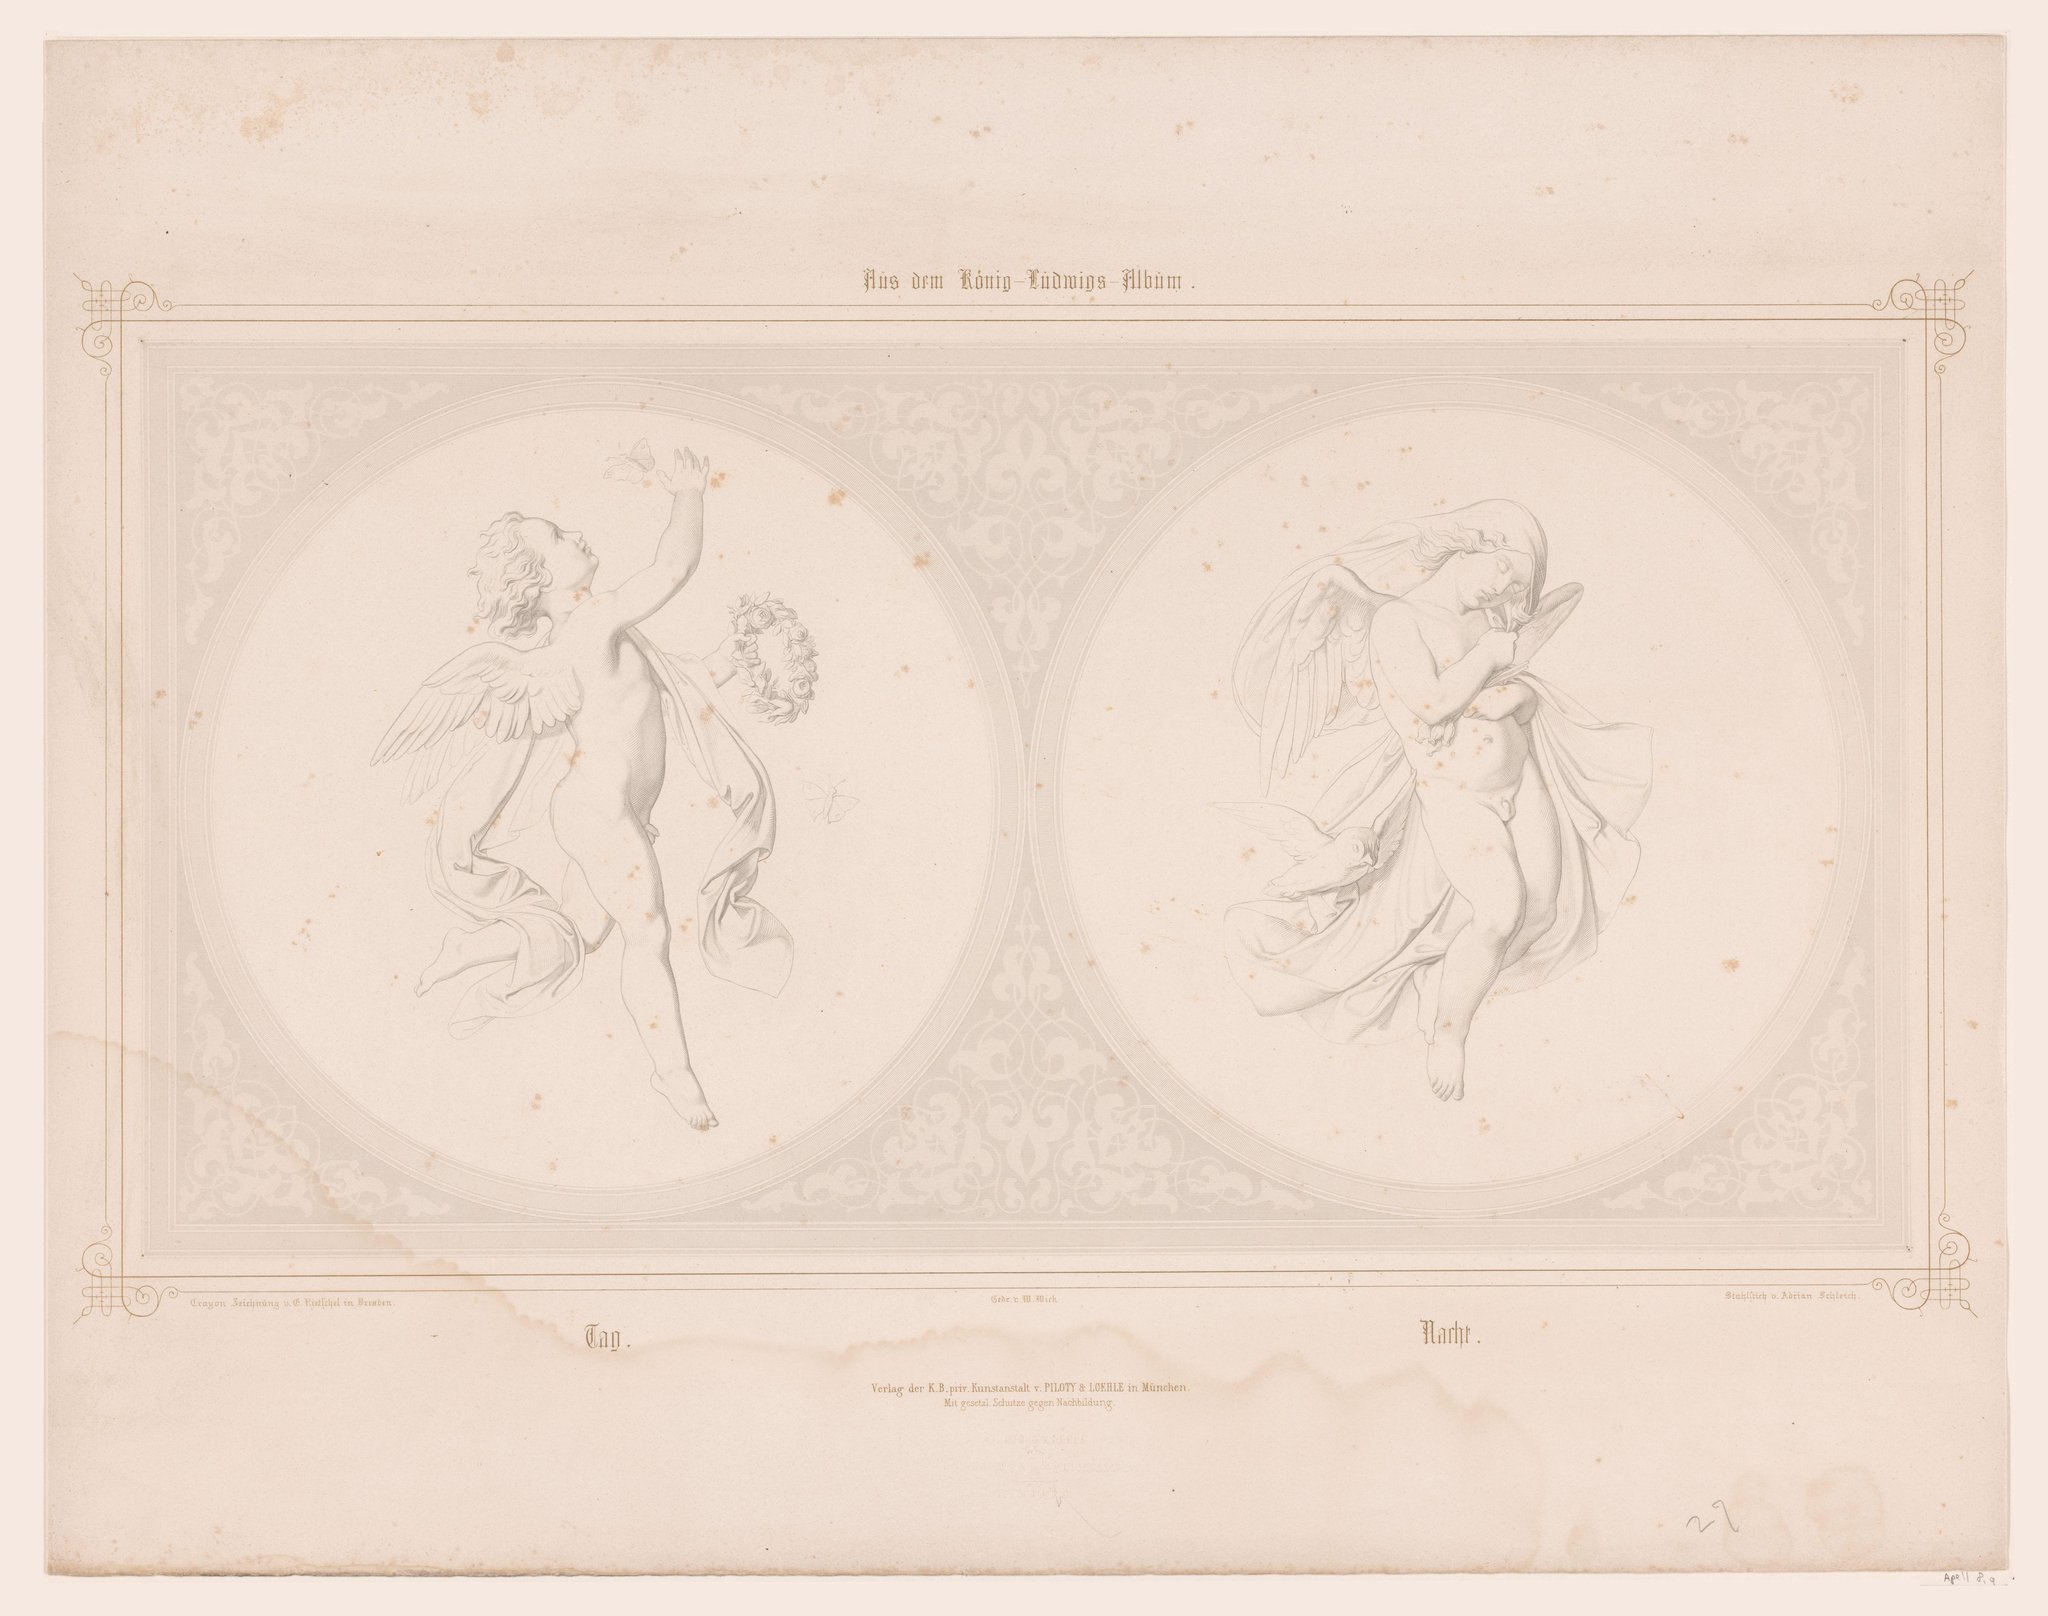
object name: print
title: Personificaties van dag en nacht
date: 1850-1859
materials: paper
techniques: lithograph, engraving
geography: munich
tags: lodewijk i (koning van beieren), day and night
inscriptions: collector's mark: Lugt 2228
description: Prent afkomstig uit de serie 'Album Seiner Majestät des Königs Ludwig I. von Bayern', verschenen in verschillende afleveringen. De prenten gaan terug op het album dat Lodewijk I van Beieren op 9 oktober 1850 kreeg overhandigd van verschillende kunstenaars.